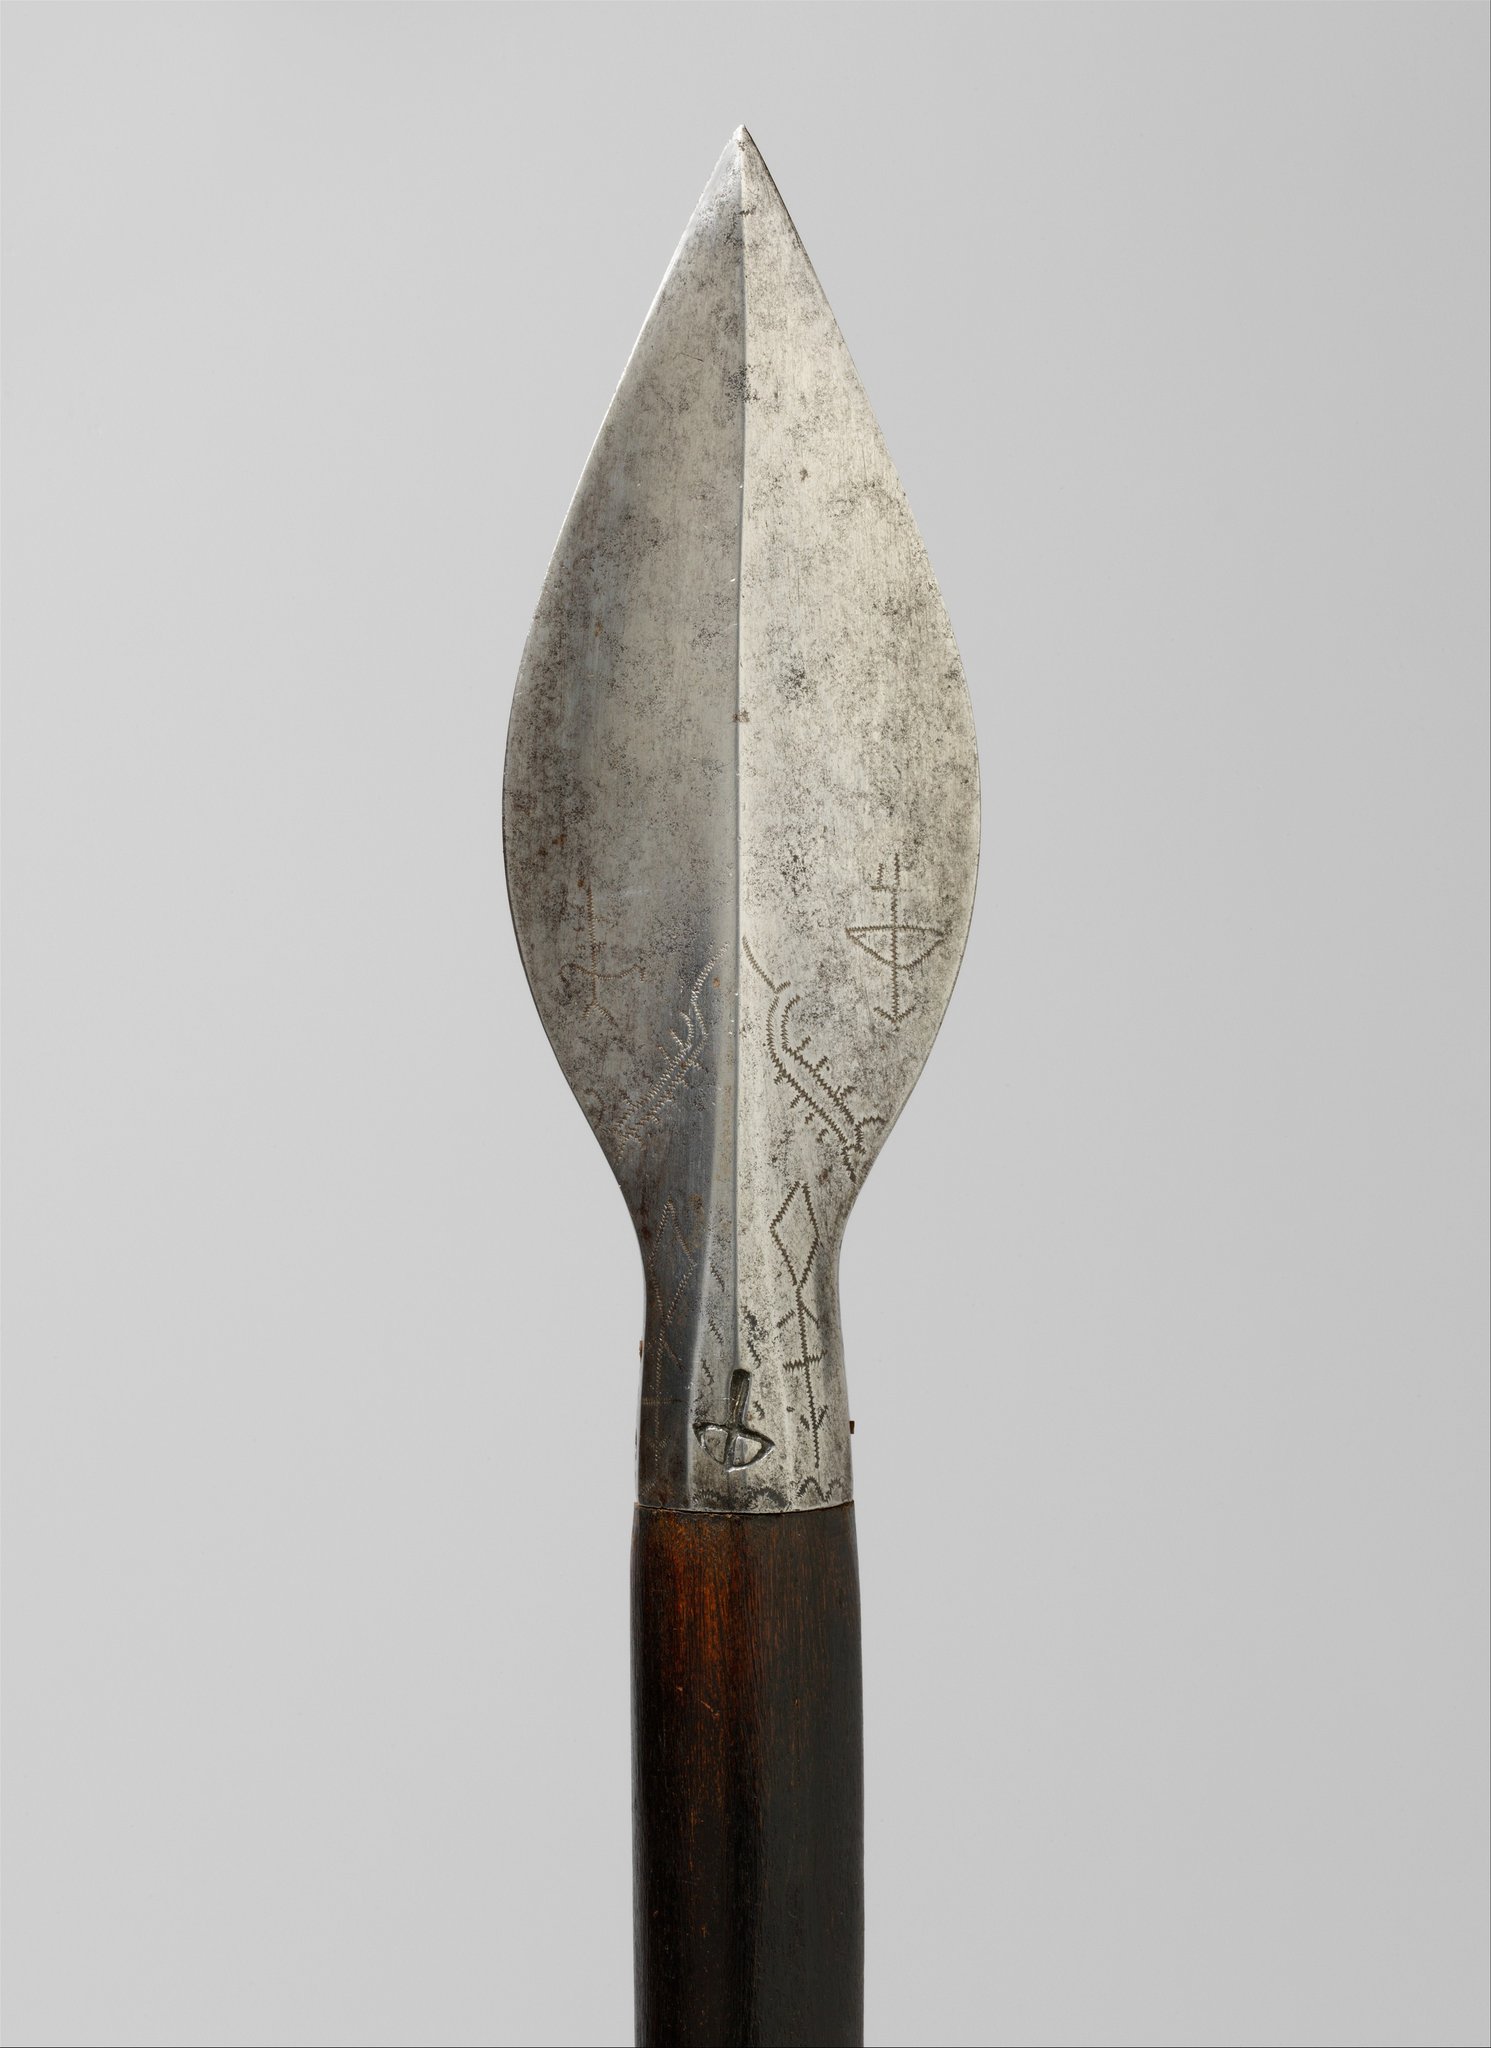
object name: lance point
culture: spanish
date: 1401-1500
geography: spain